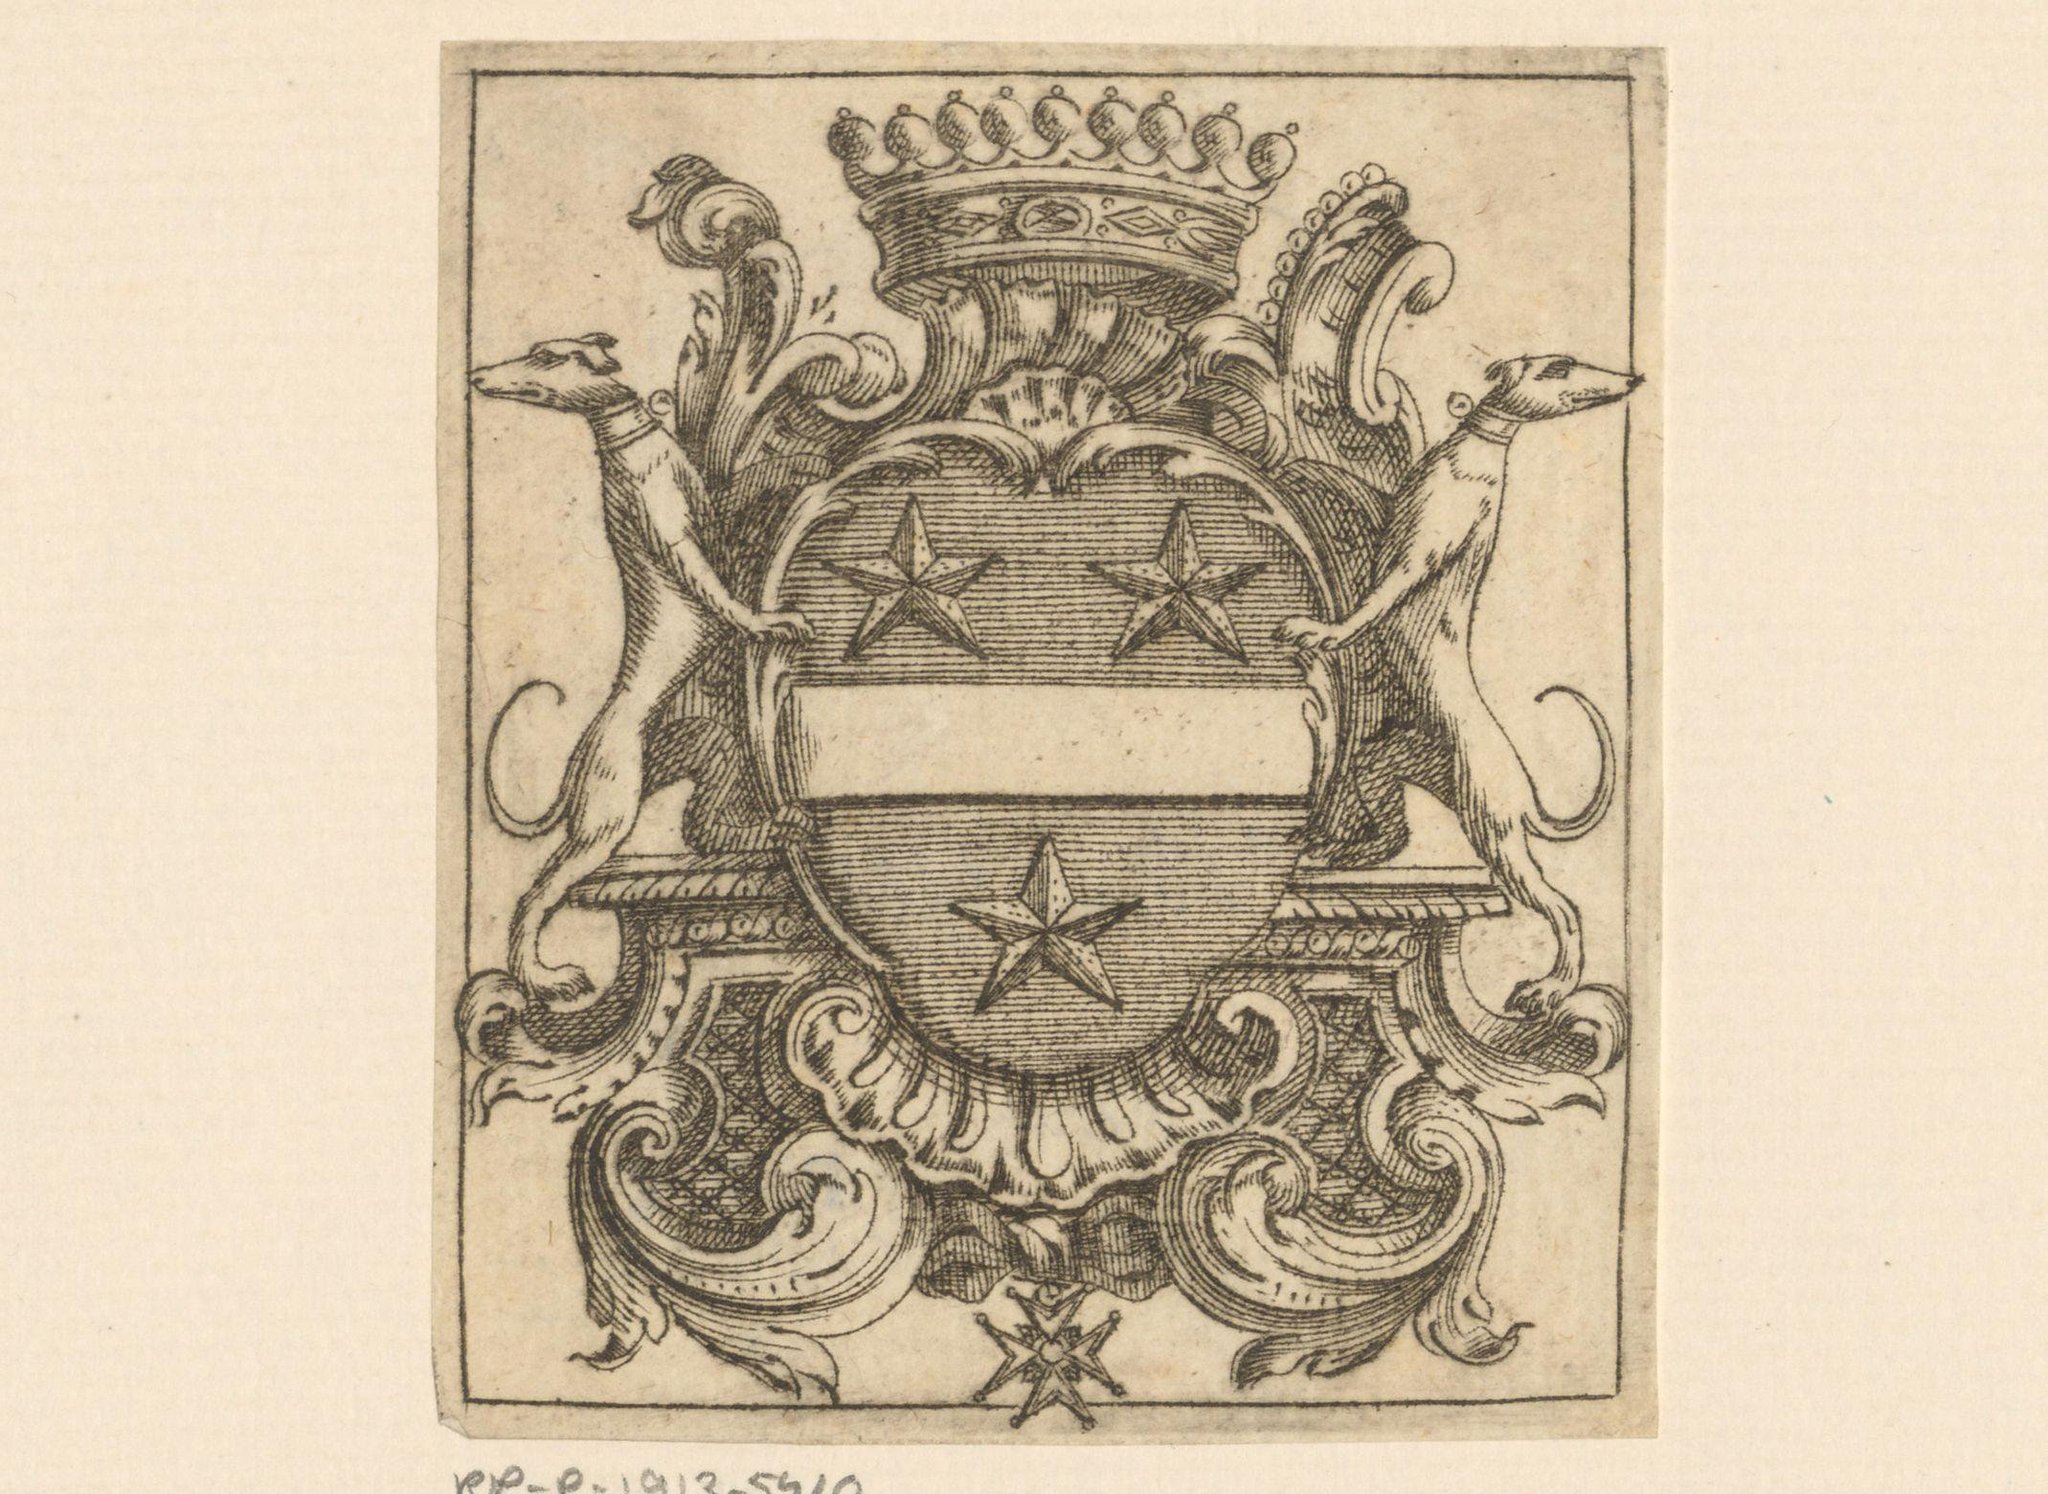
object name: bookplate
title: Ex libris van Jean François Etienne Grimod de Bénéon, baron de Rieverie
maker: Anonymous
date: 1650-1799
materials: paper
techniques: engraving, etching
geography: france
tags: stars, beasts of prey, predatory animals: lion, armorial bearing, heraldry, dog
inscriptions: collector's mark: Lugt 2233, collector's mark: Lugt 2760